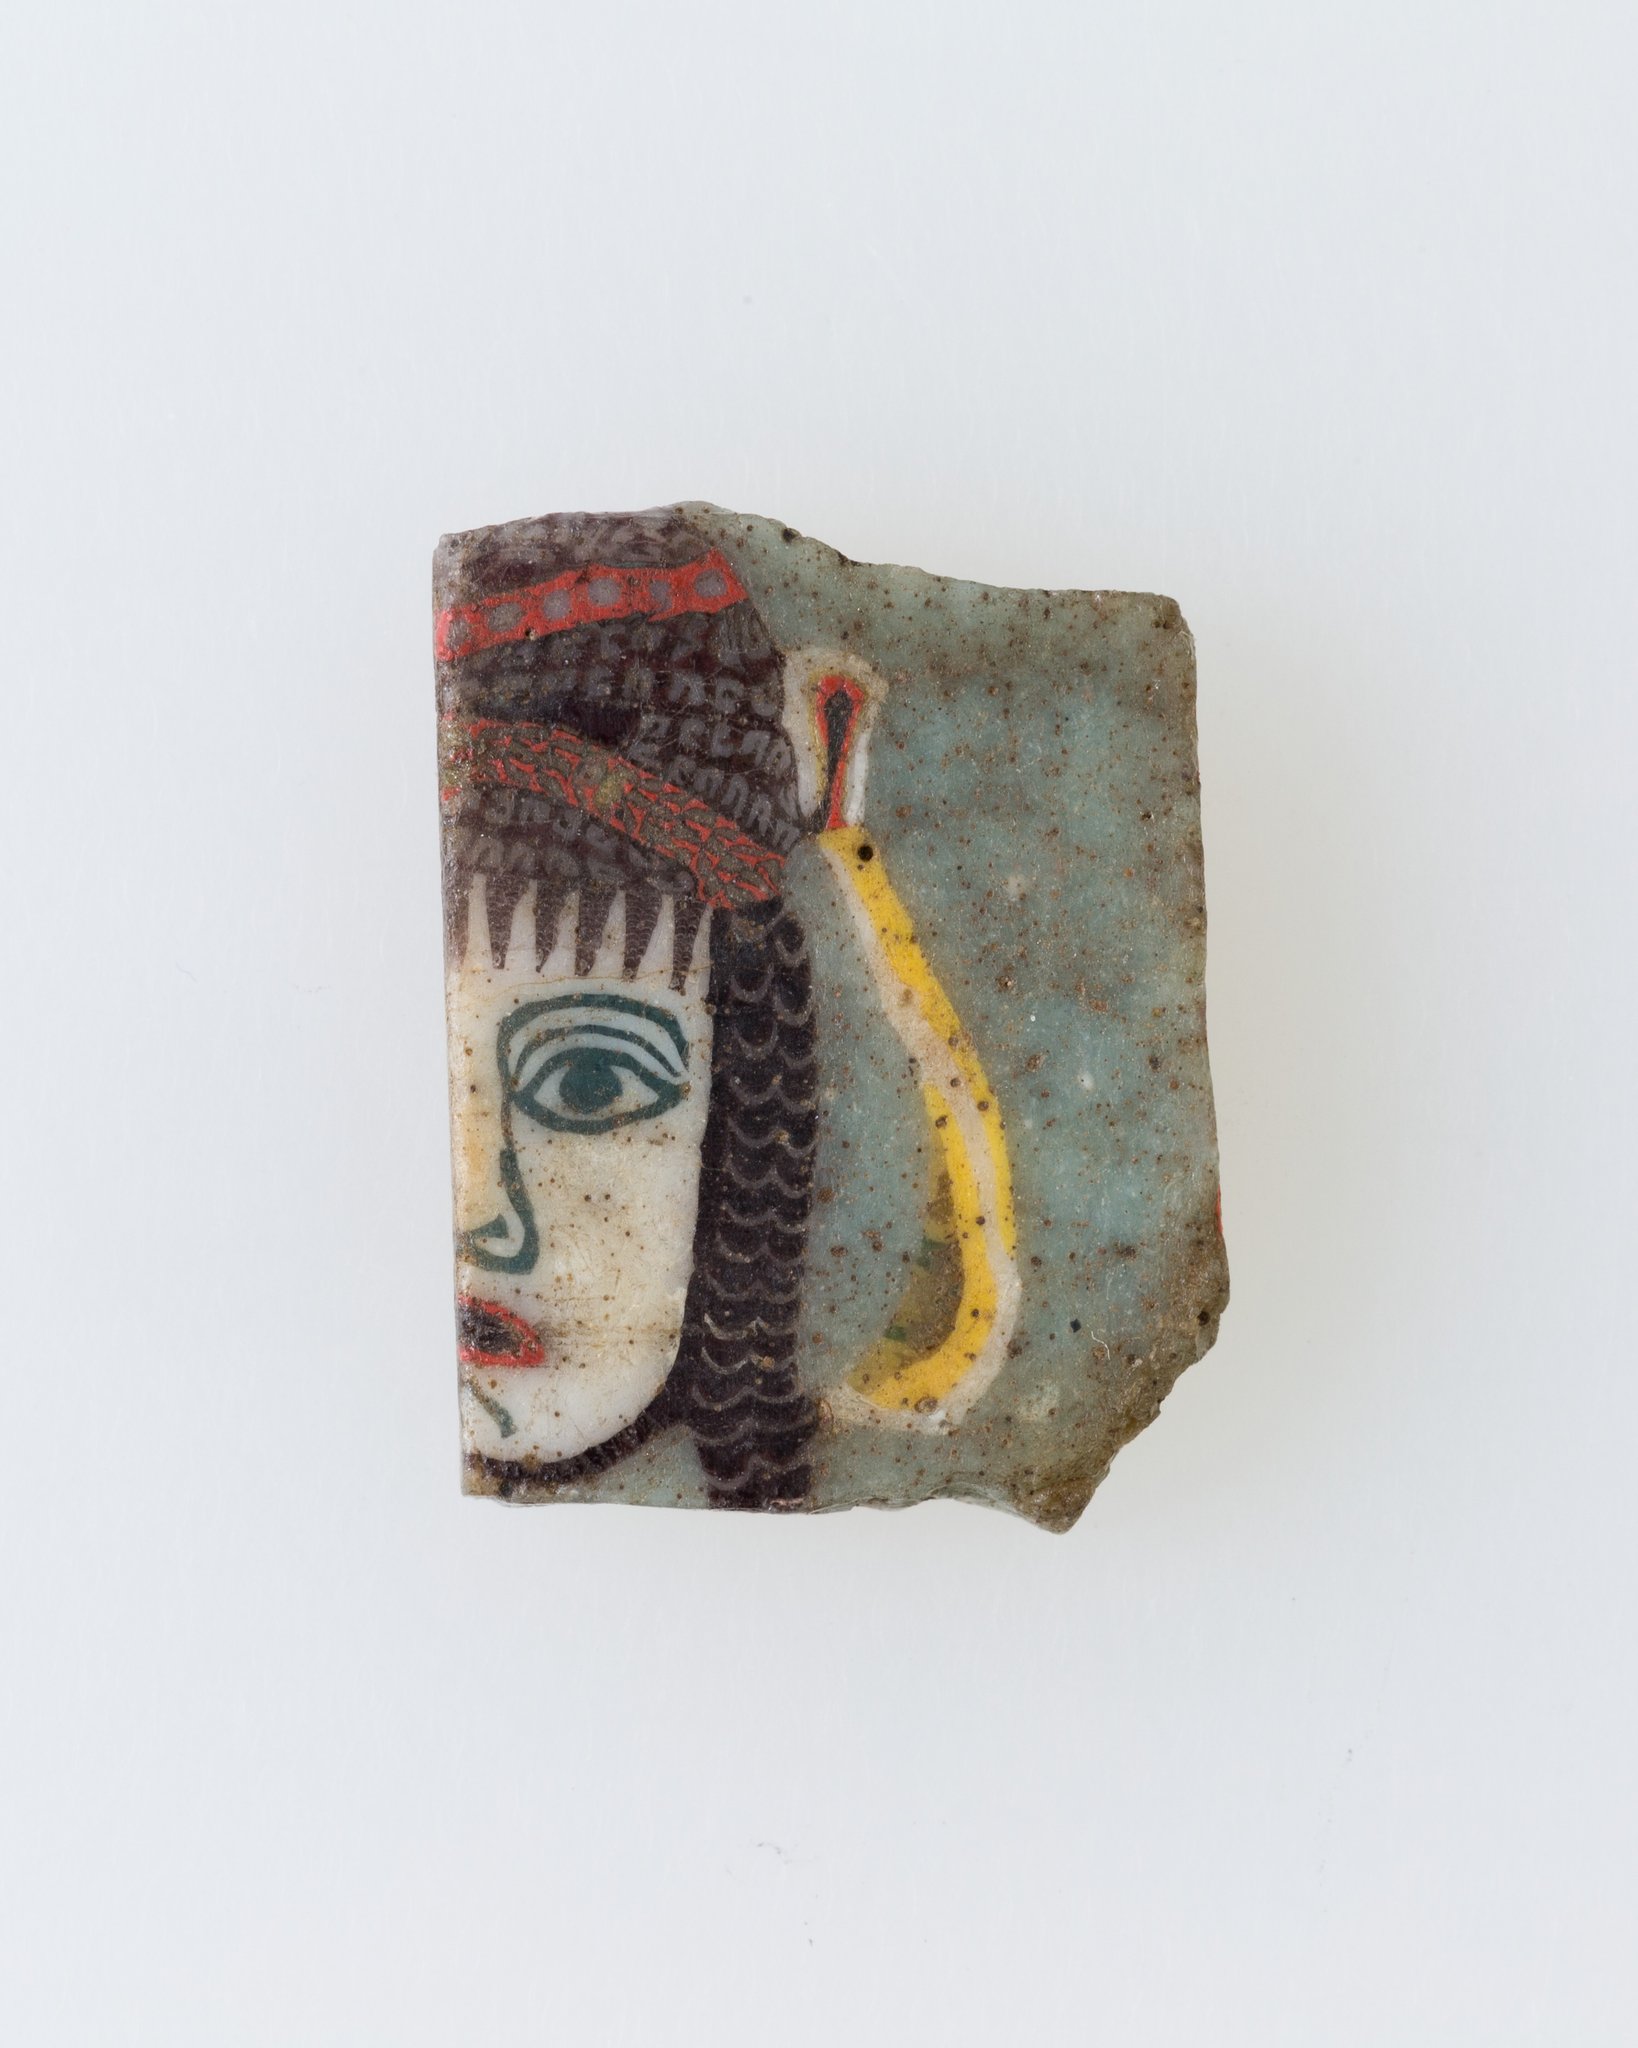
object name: inlay, female face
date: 100 BCE-100 CE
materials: glass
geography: egypt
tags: faces,women